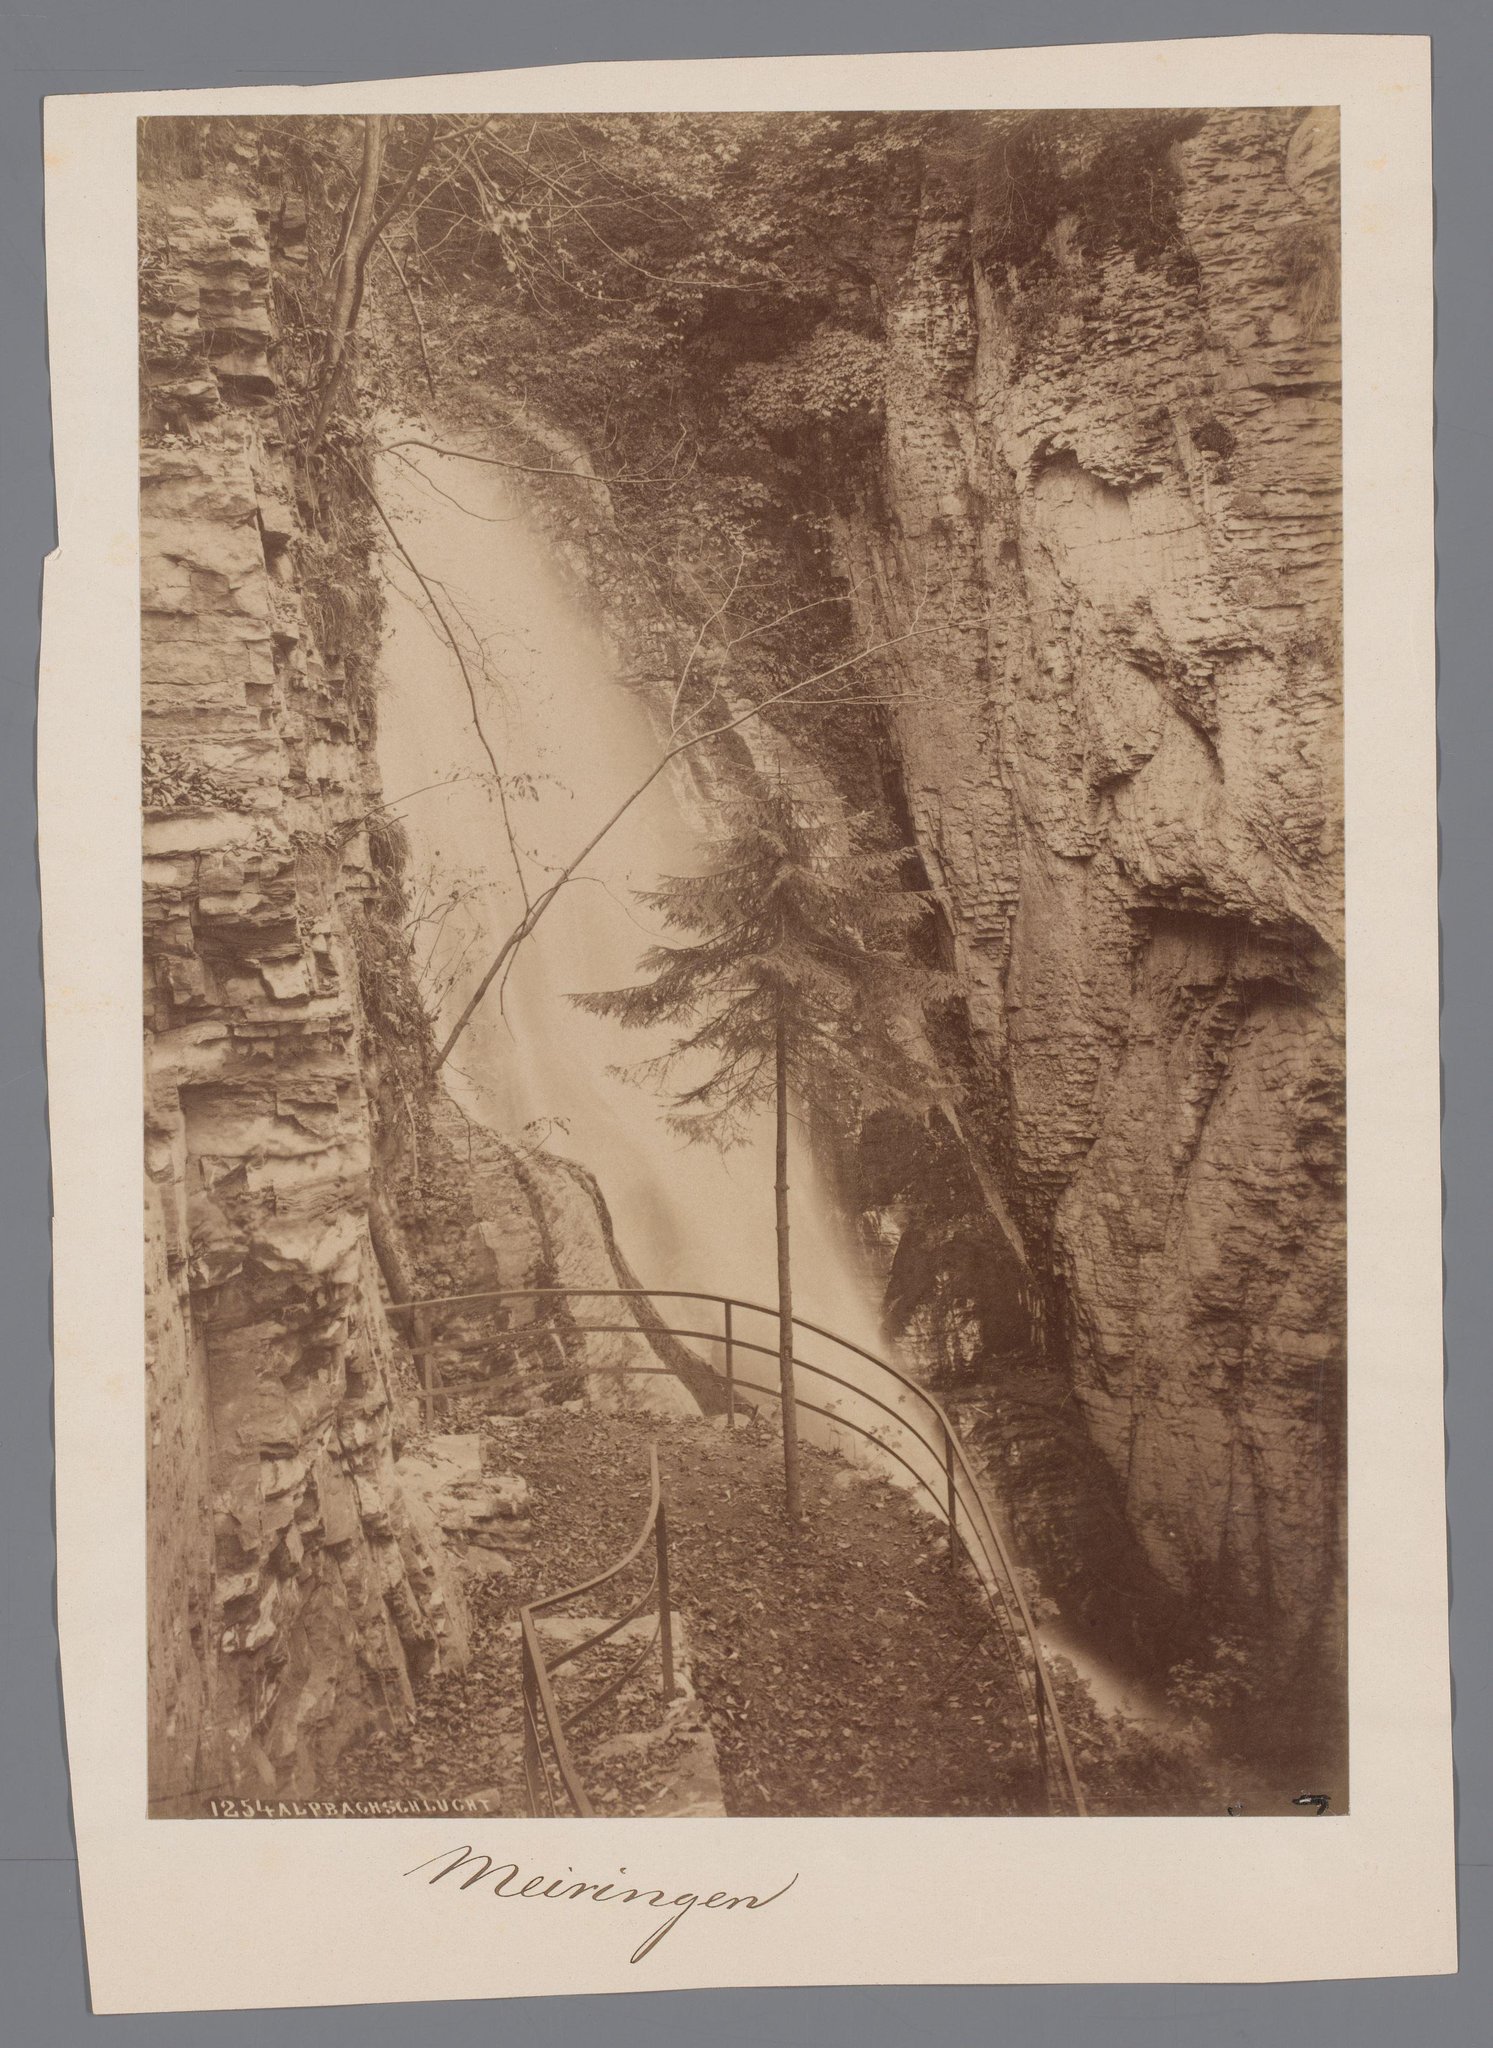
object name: photograph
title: Waterval, Alpbachschlucht, Meiringen, Zwitserland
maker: Anonymous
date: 1890-1915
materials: paper, photographic support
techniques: albumen print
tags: switzerland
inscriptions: inscription: ‘1254 ALPBACHSCHLUCHT’, inscription: ‘Meiringen’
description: Deze kloof bij de Hasliberg in het Berner Oberland werd in de zomer van 1891 toegankelijk voor het publiek. Er is een platform met hek te zien van waaruit de waterval kan worden bekeken.